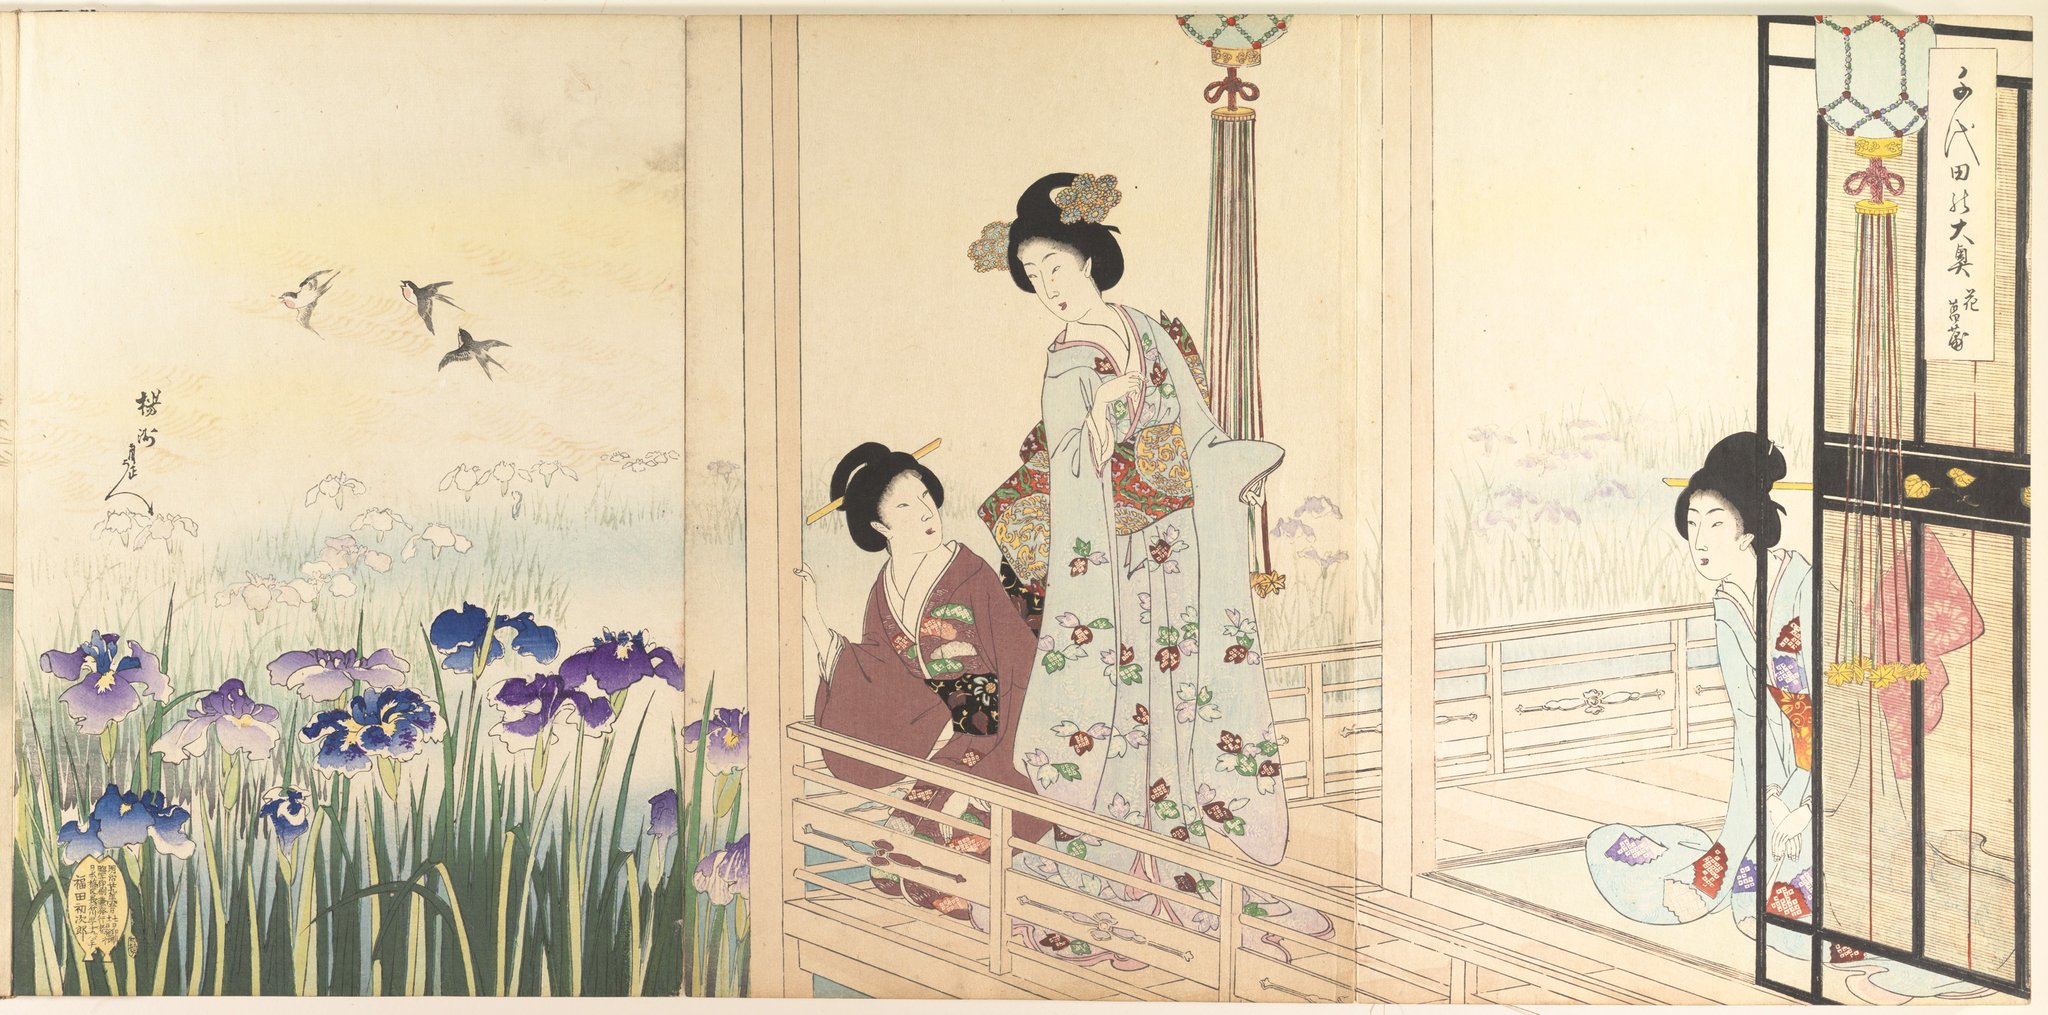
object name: print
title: Chiyoda Castle (Album of Women)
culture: japanese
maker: yōshū (hashimoto) chikanobu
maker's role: artist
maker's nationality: japanese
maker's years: 1838-1912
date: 1895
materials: ink, paper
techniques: woodblock print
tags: birds,buildings,women,flowers